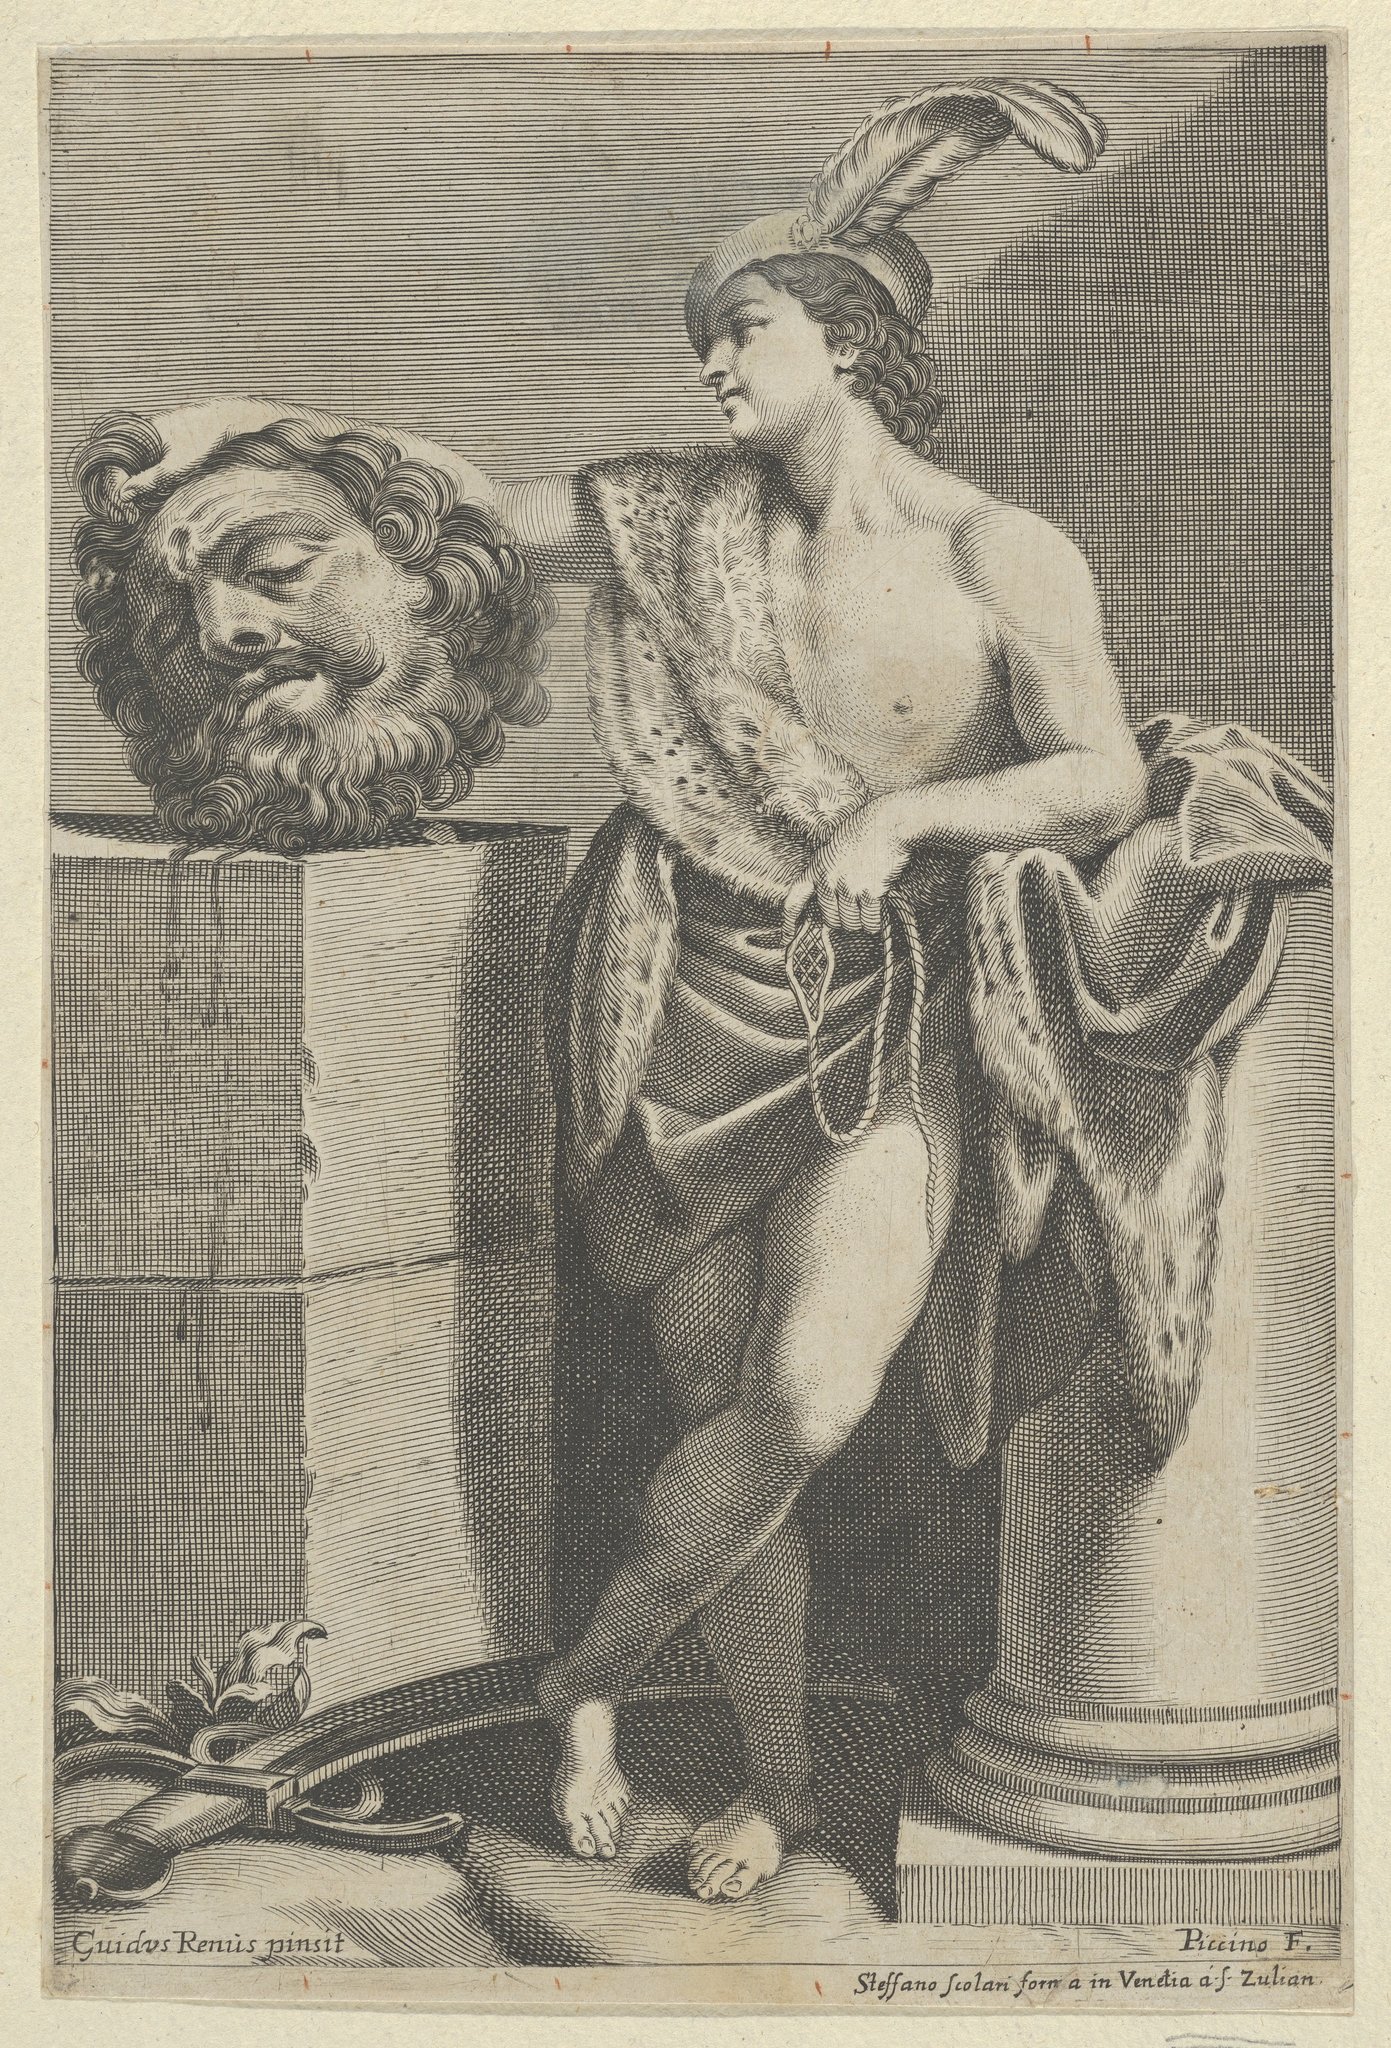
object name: print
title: David standing with crossed legs and holding the head of Goliath on a pedestal at left, a sword on the ground, after Reni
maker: giacomo piccini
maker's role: artist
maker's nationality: italian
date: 1635-1670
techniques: engraving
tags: heads,david